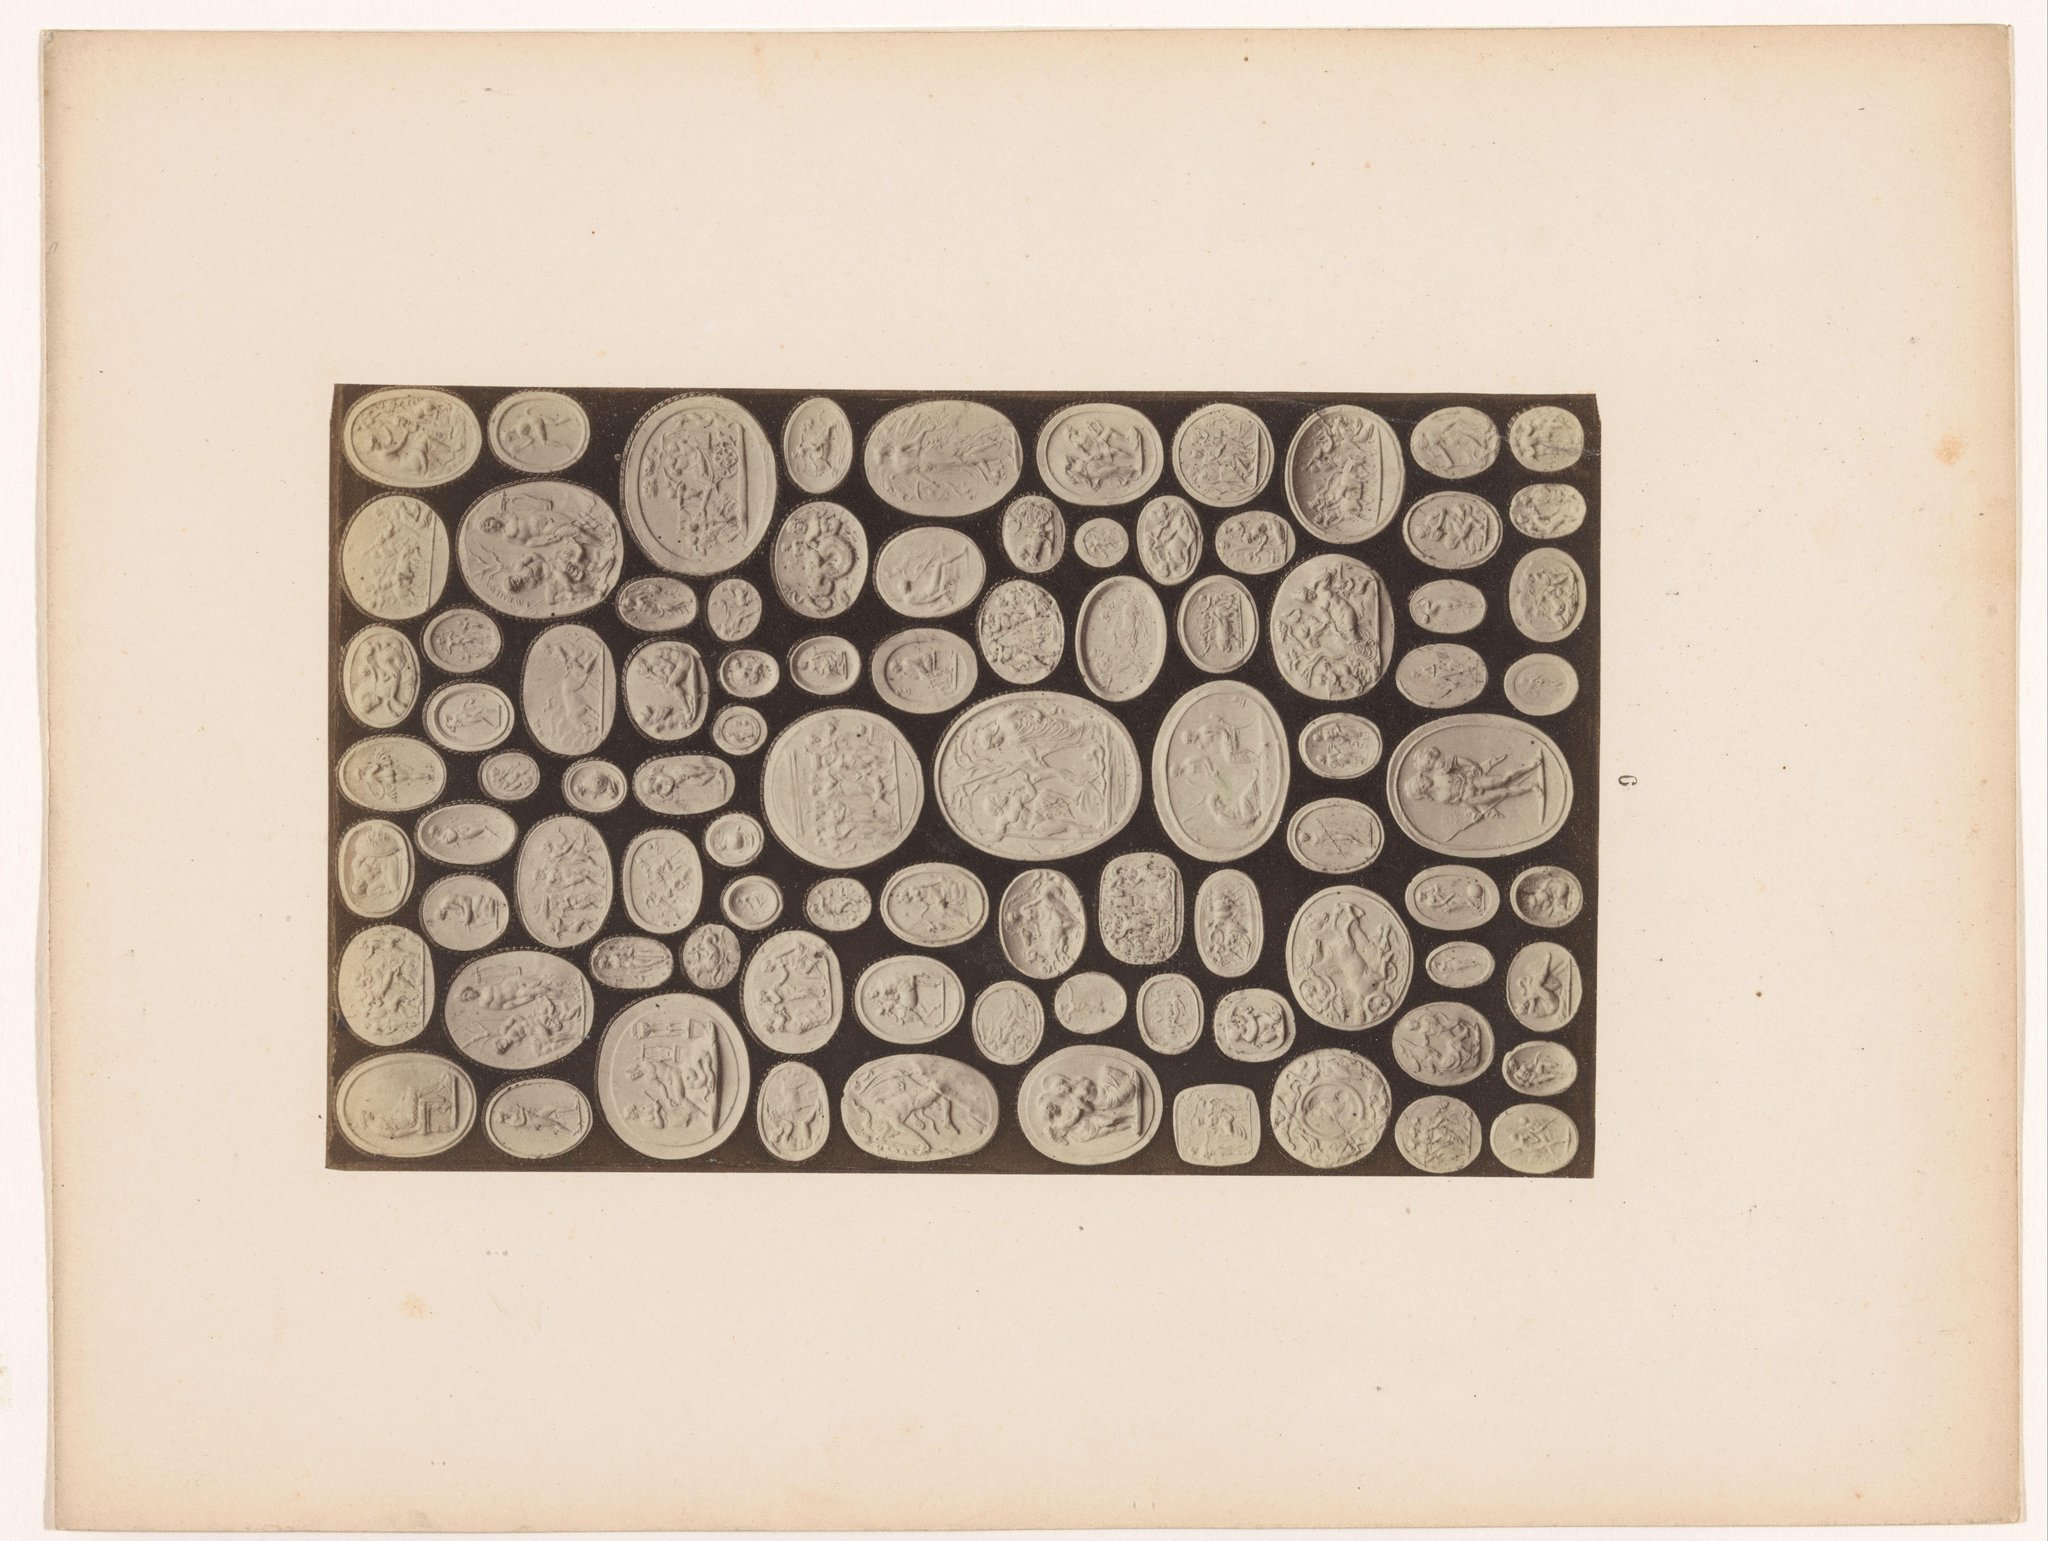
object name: photograph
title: Cameeën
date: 1859-1882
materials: cardboard, paper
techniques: albumen print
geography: france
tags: sculpture, gem, gemstone, france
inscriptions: number: ‘9’